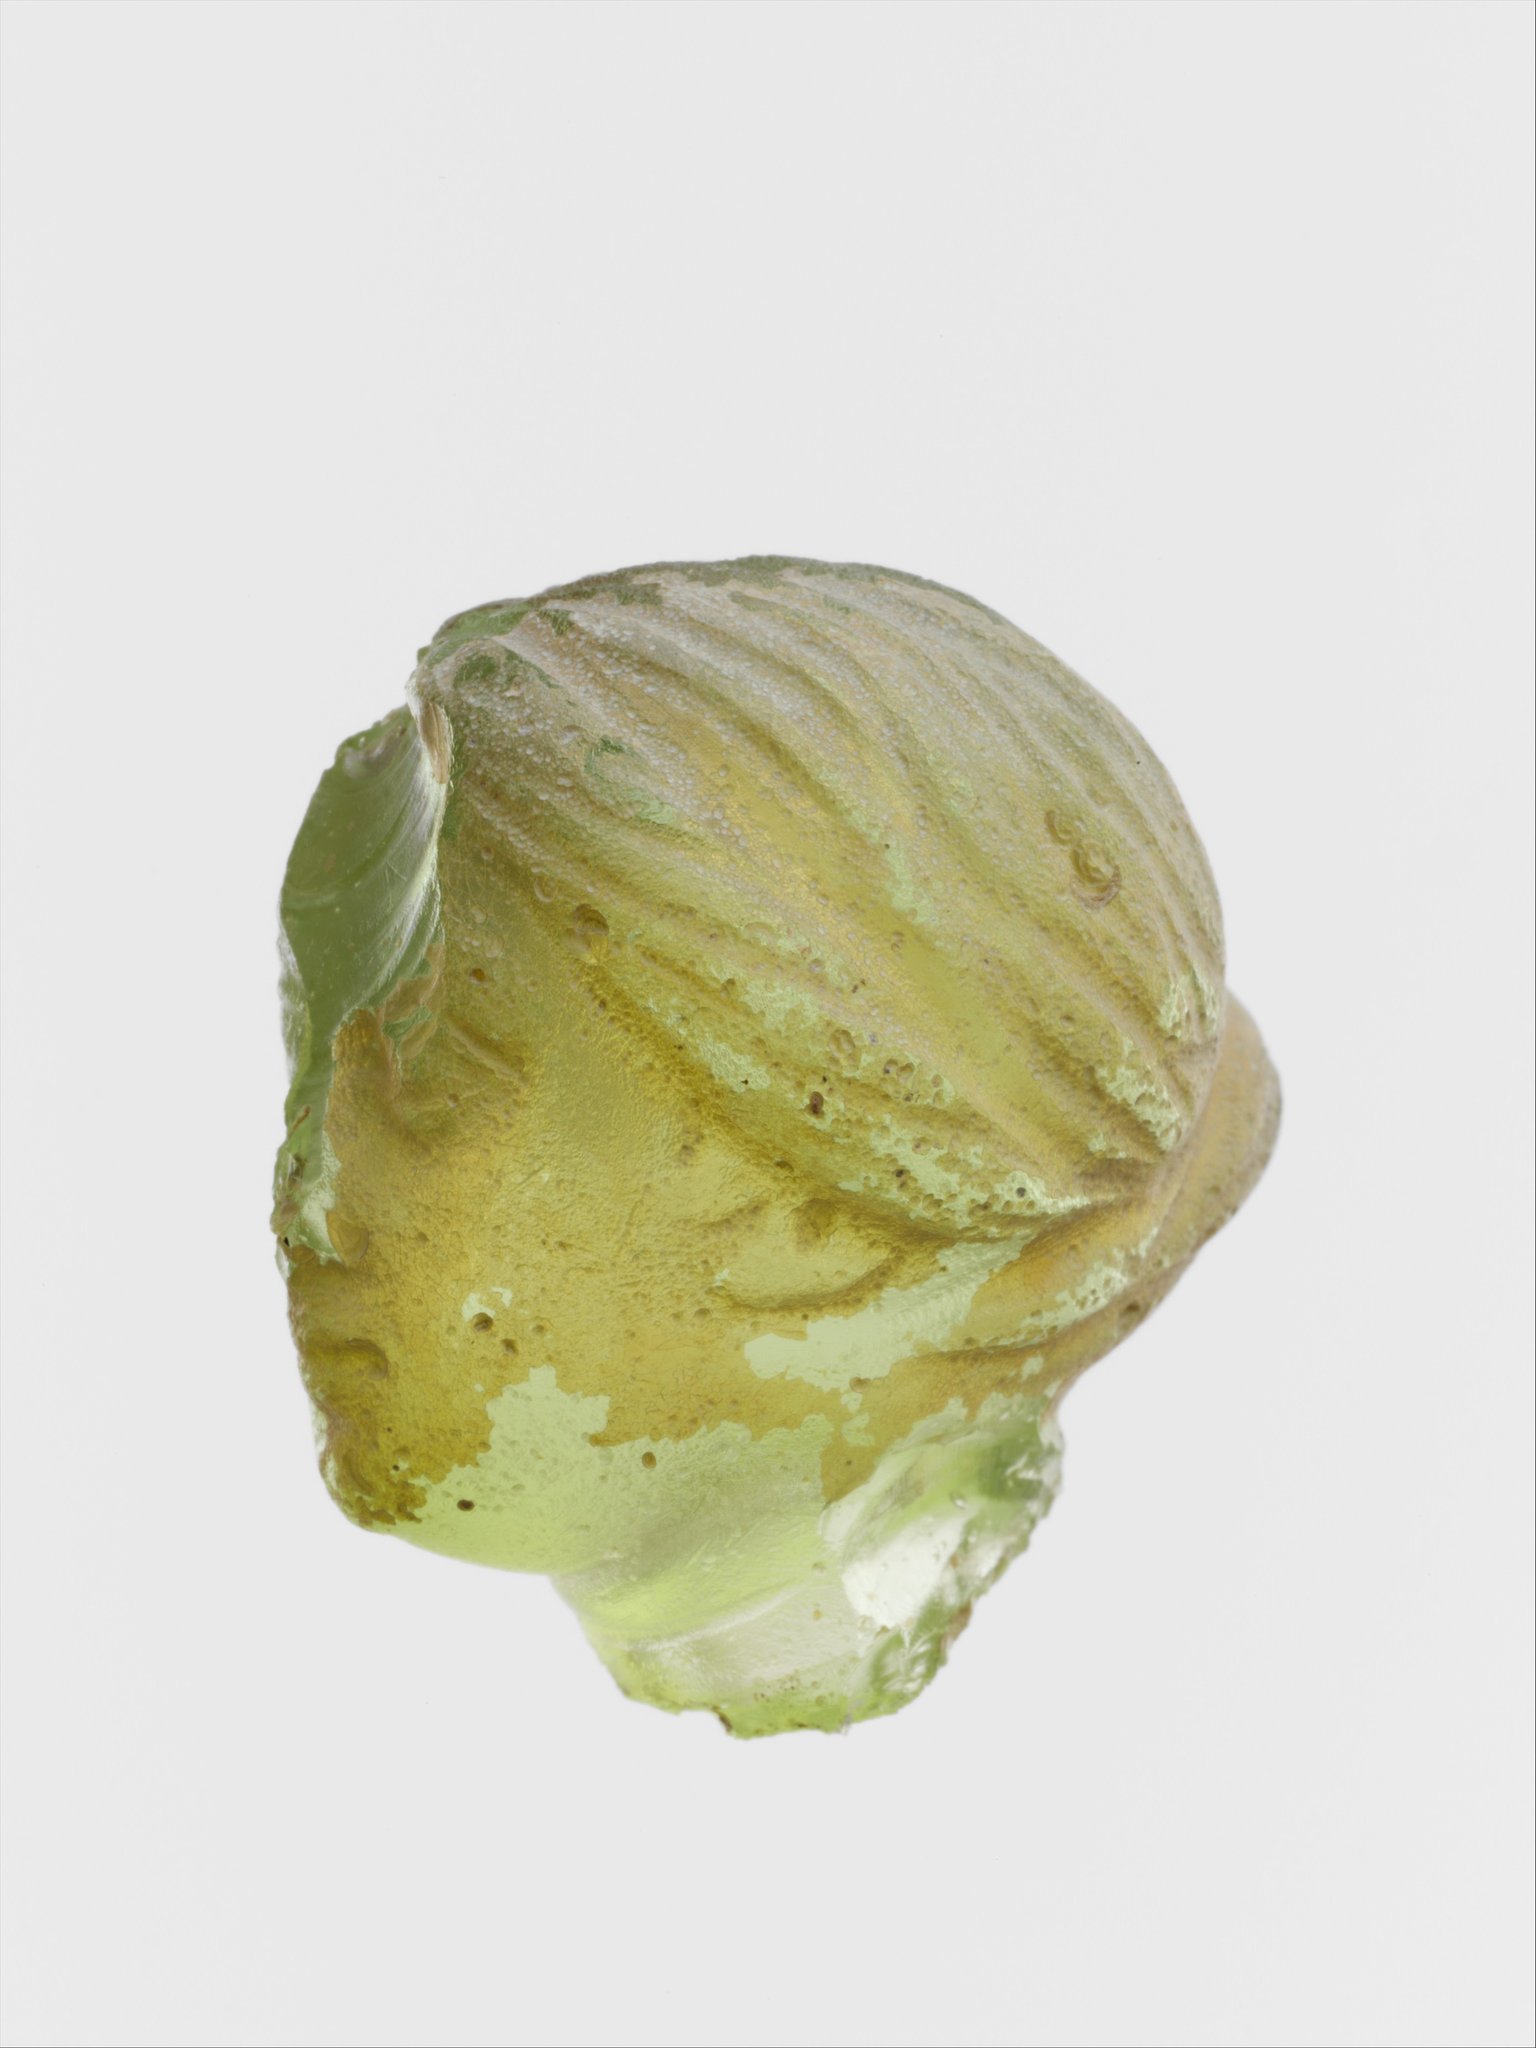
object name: head, female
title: Glass head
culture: egyptian or greek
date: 200-101 BCE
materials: glass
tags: heads,women